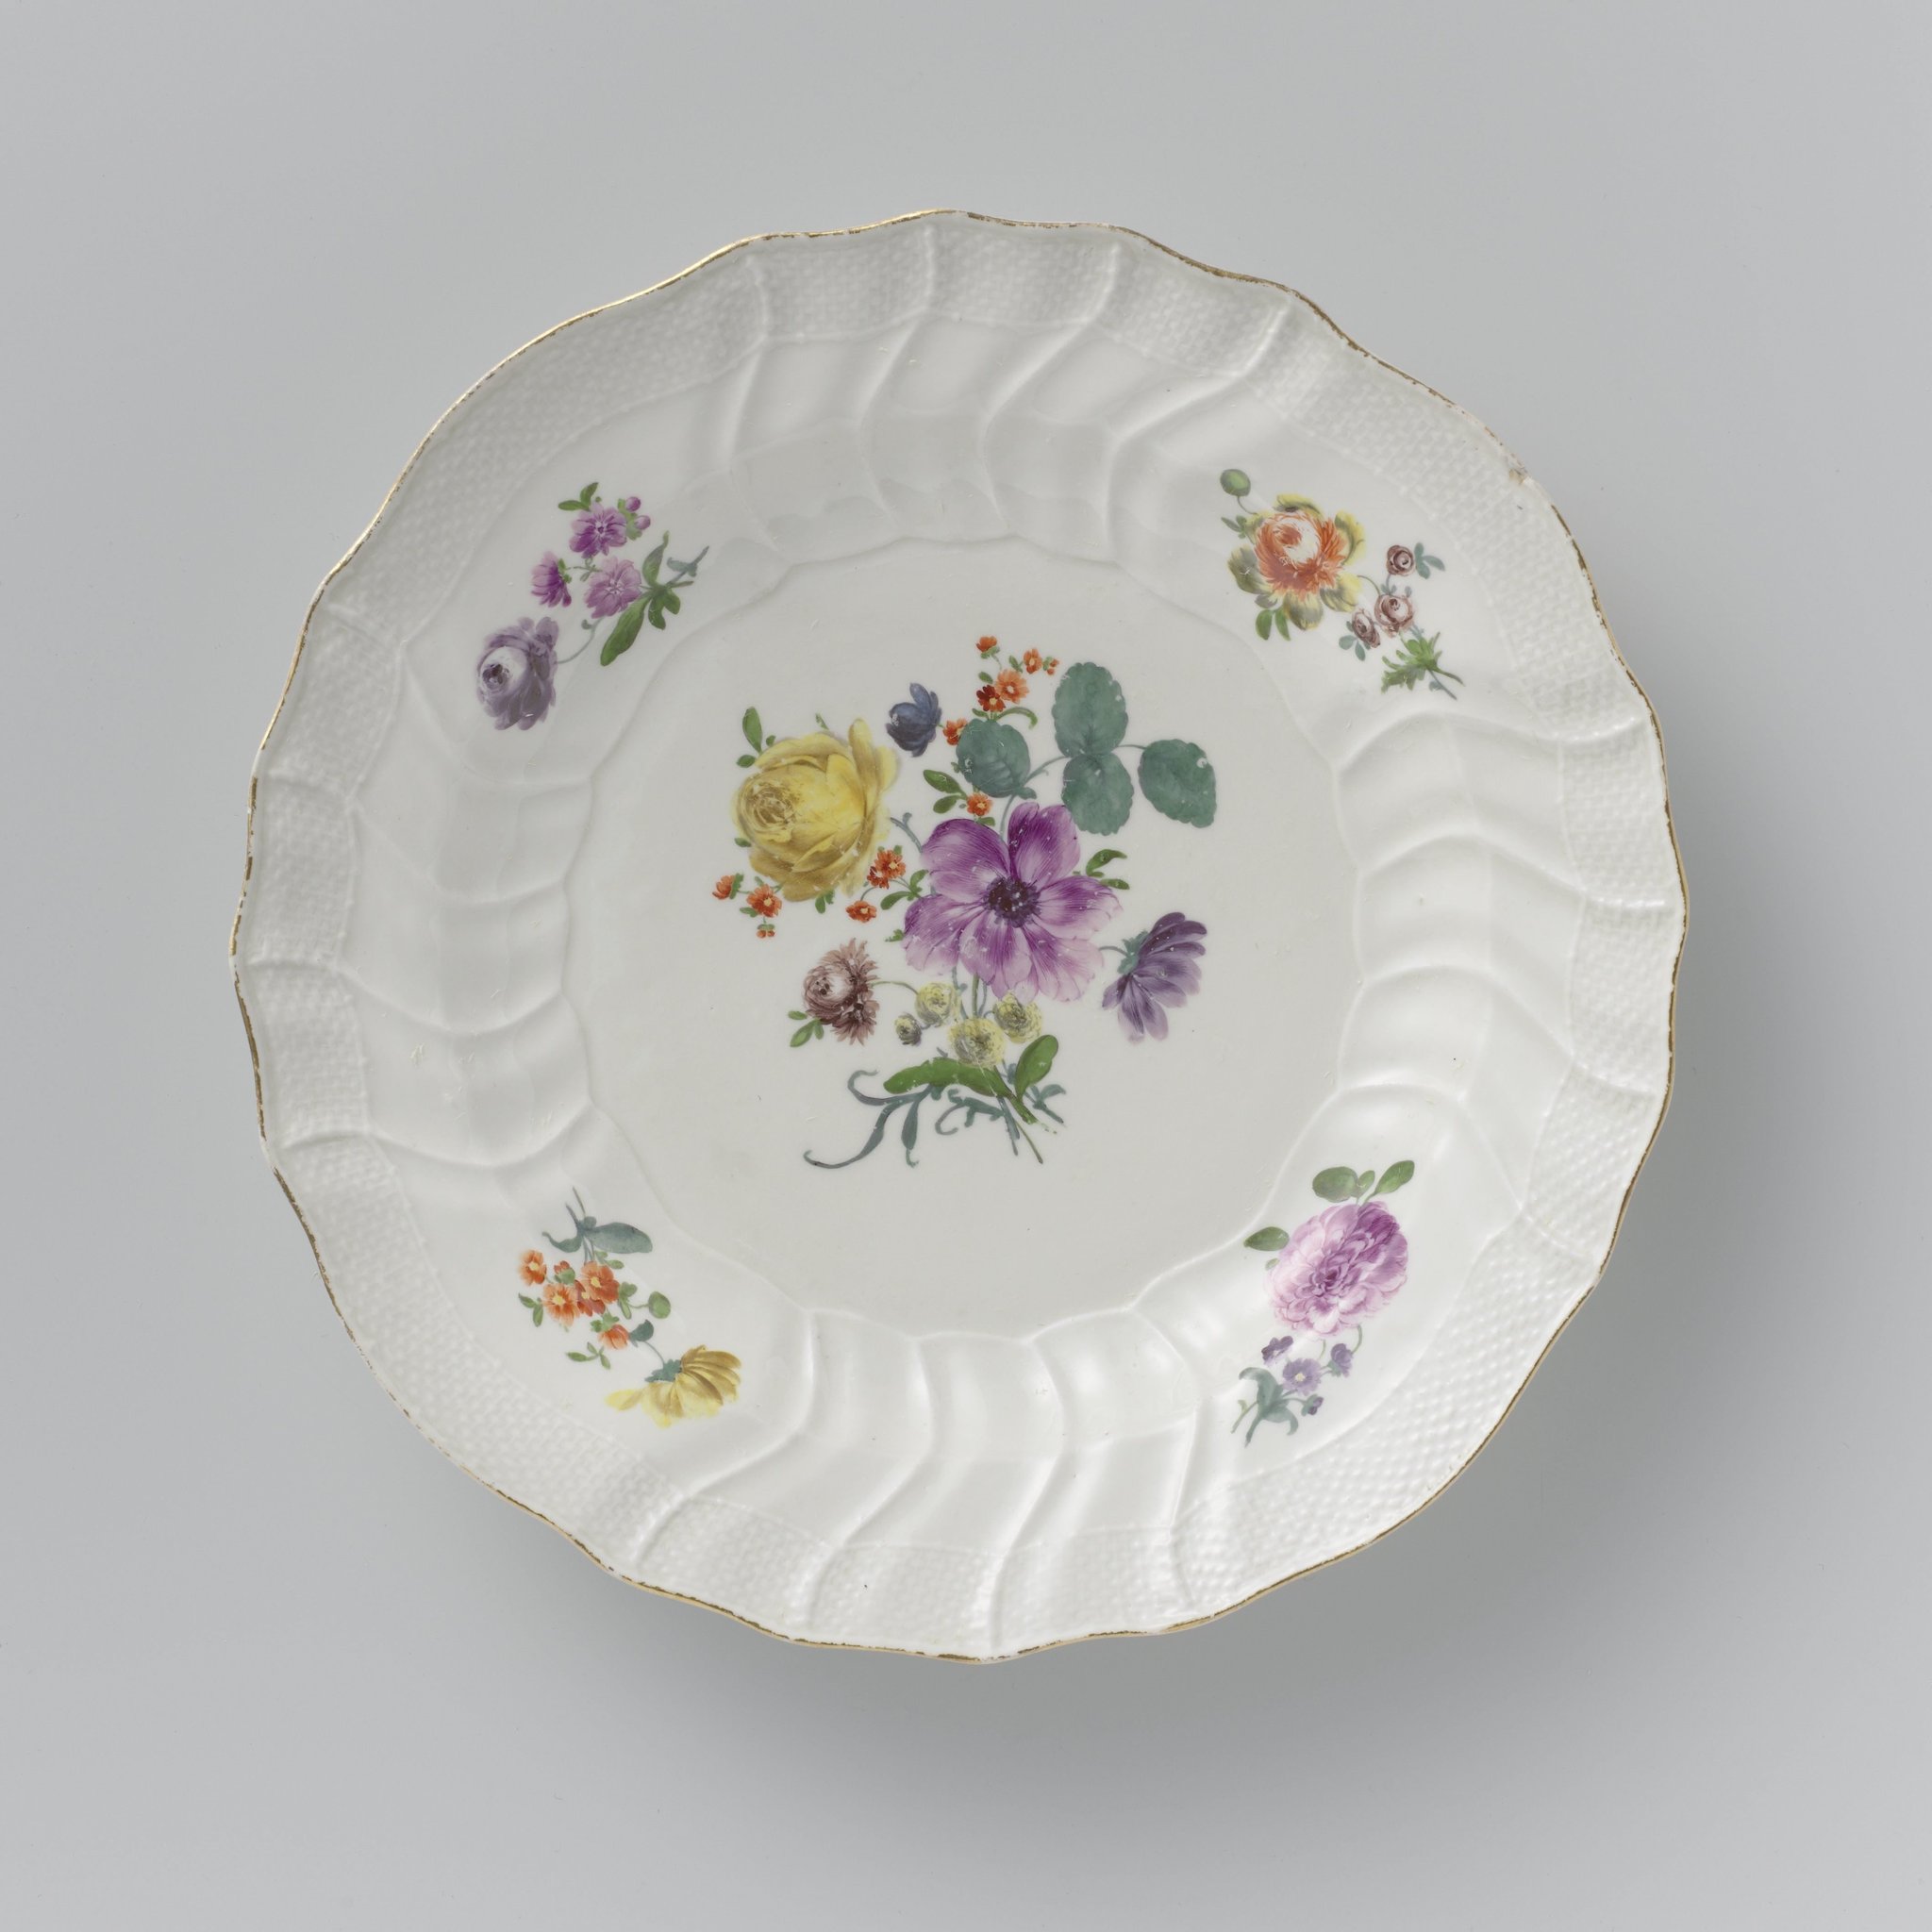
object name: plate dish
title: Bord, veelkleurig beschilderd met Deutsche Blumen, insekten en vruchten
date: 1750-1760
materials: porcelain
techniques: painted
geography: meissen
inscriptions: factory mark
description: Rond bord van beschilderd porselein. De rand is versierd met het Neuozier-patroon in reliëf. De beschildering bestaat uit Deutsche Blumen, insekten en vruchten. Het bord is gemerkt en hoort bij een servies (BK-17474-1 t/m BK-17474-253).